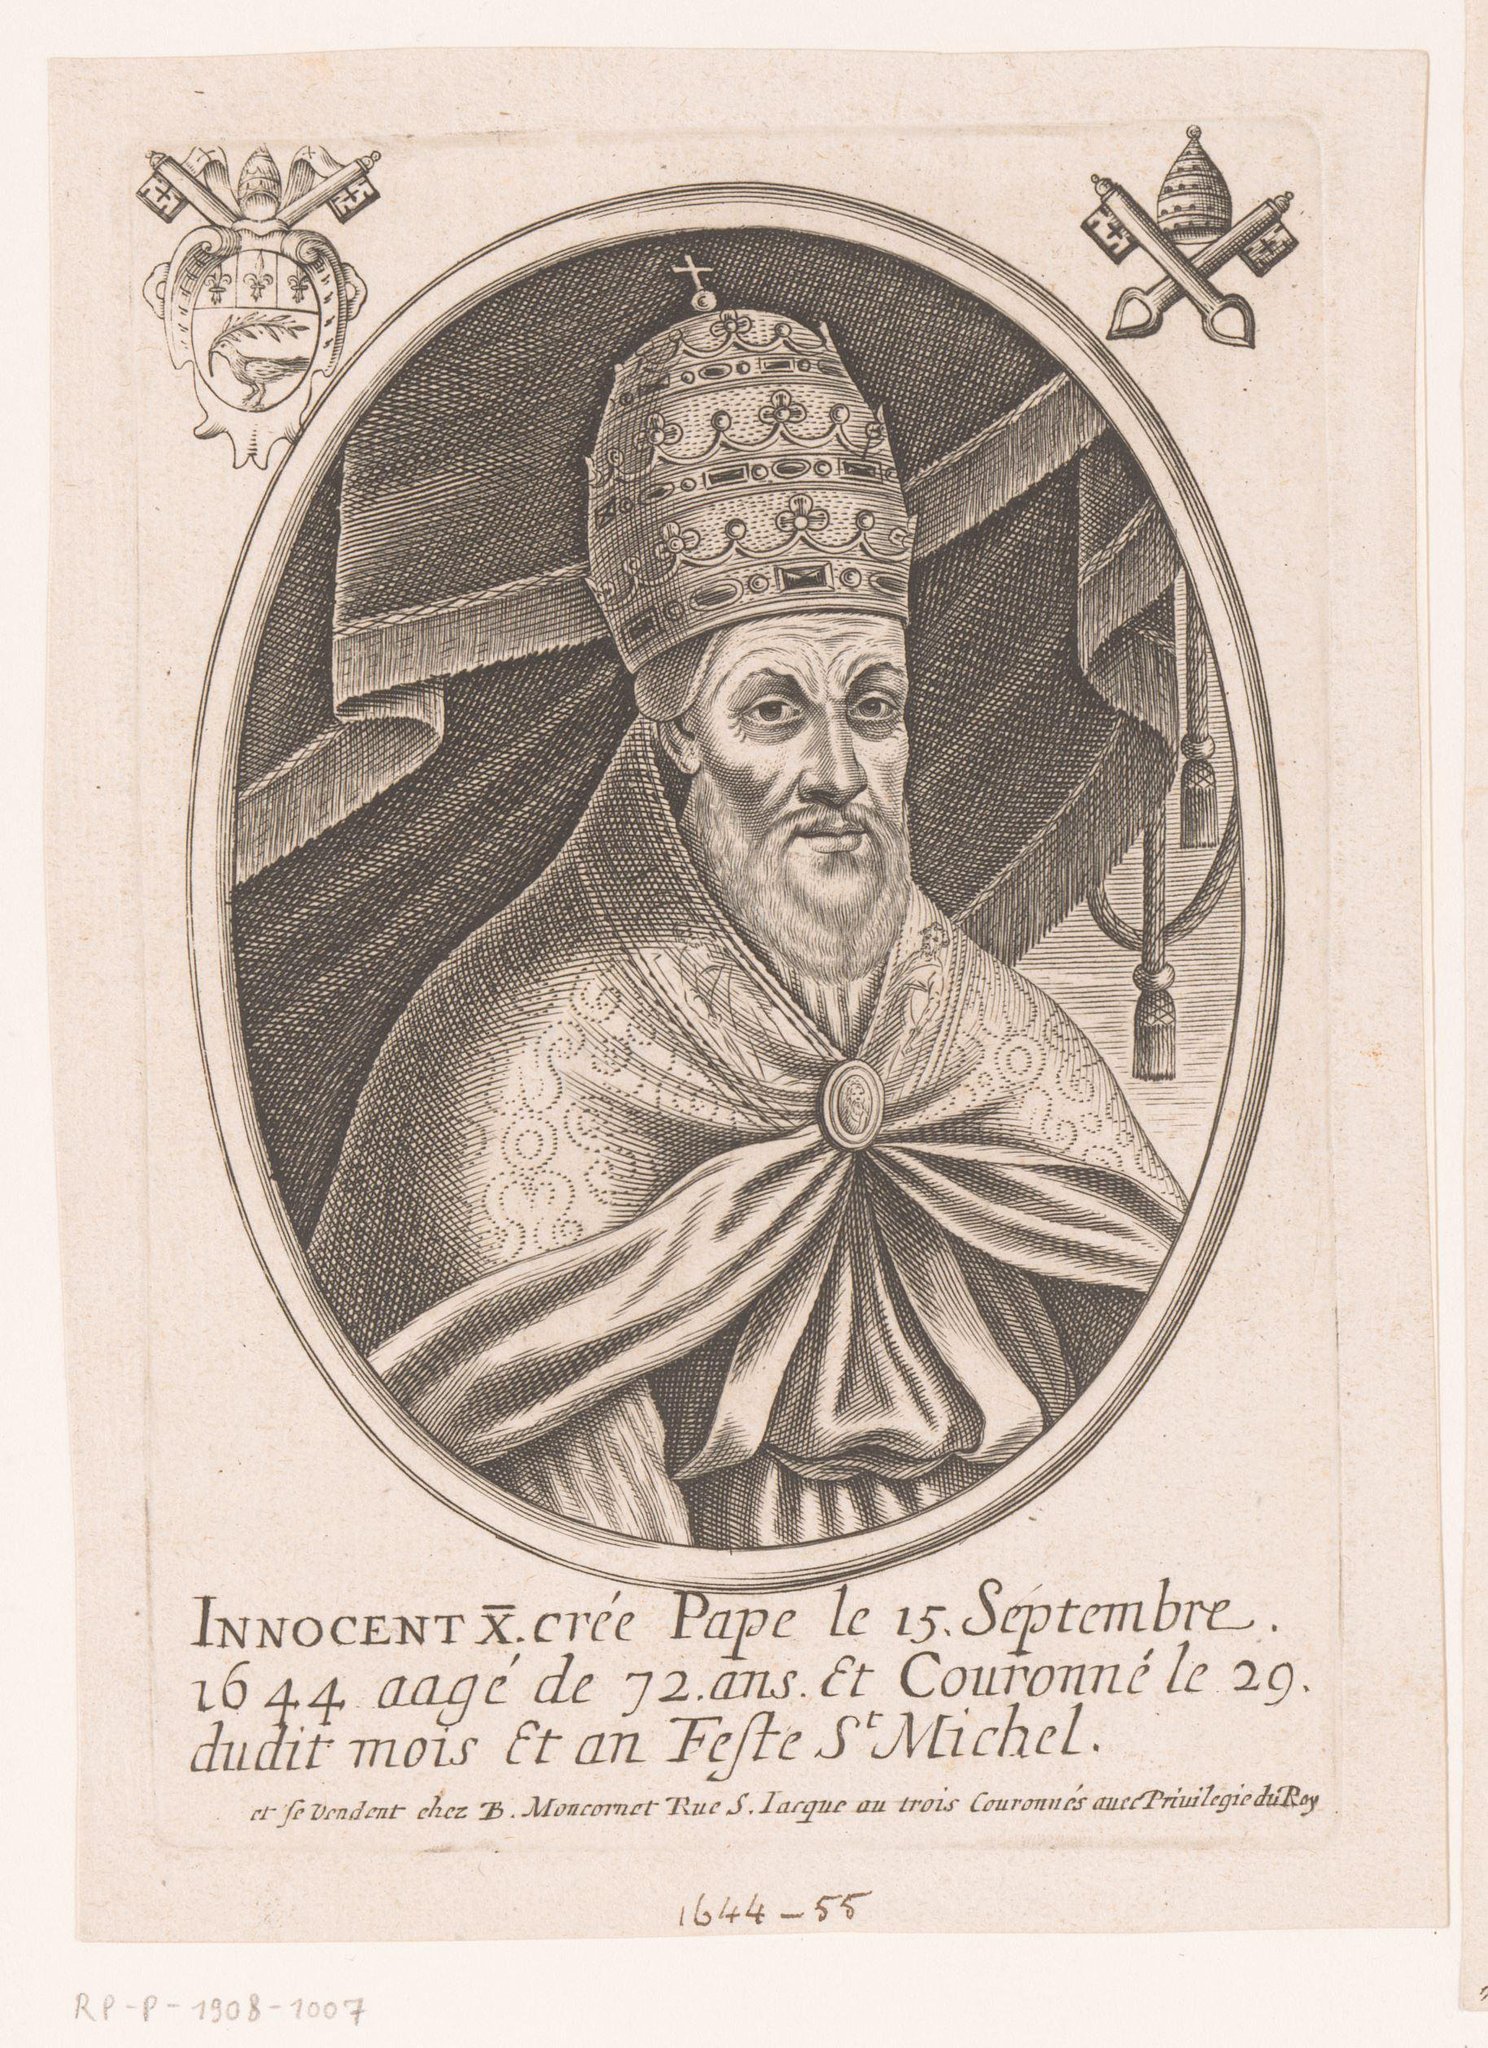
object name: print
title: Portret van paus Innocentius X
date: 1624-1668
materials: paper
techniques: engraving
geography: france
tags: rome, innocentius x, historical persons, pope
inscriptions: collector's mark: Lugt 2228